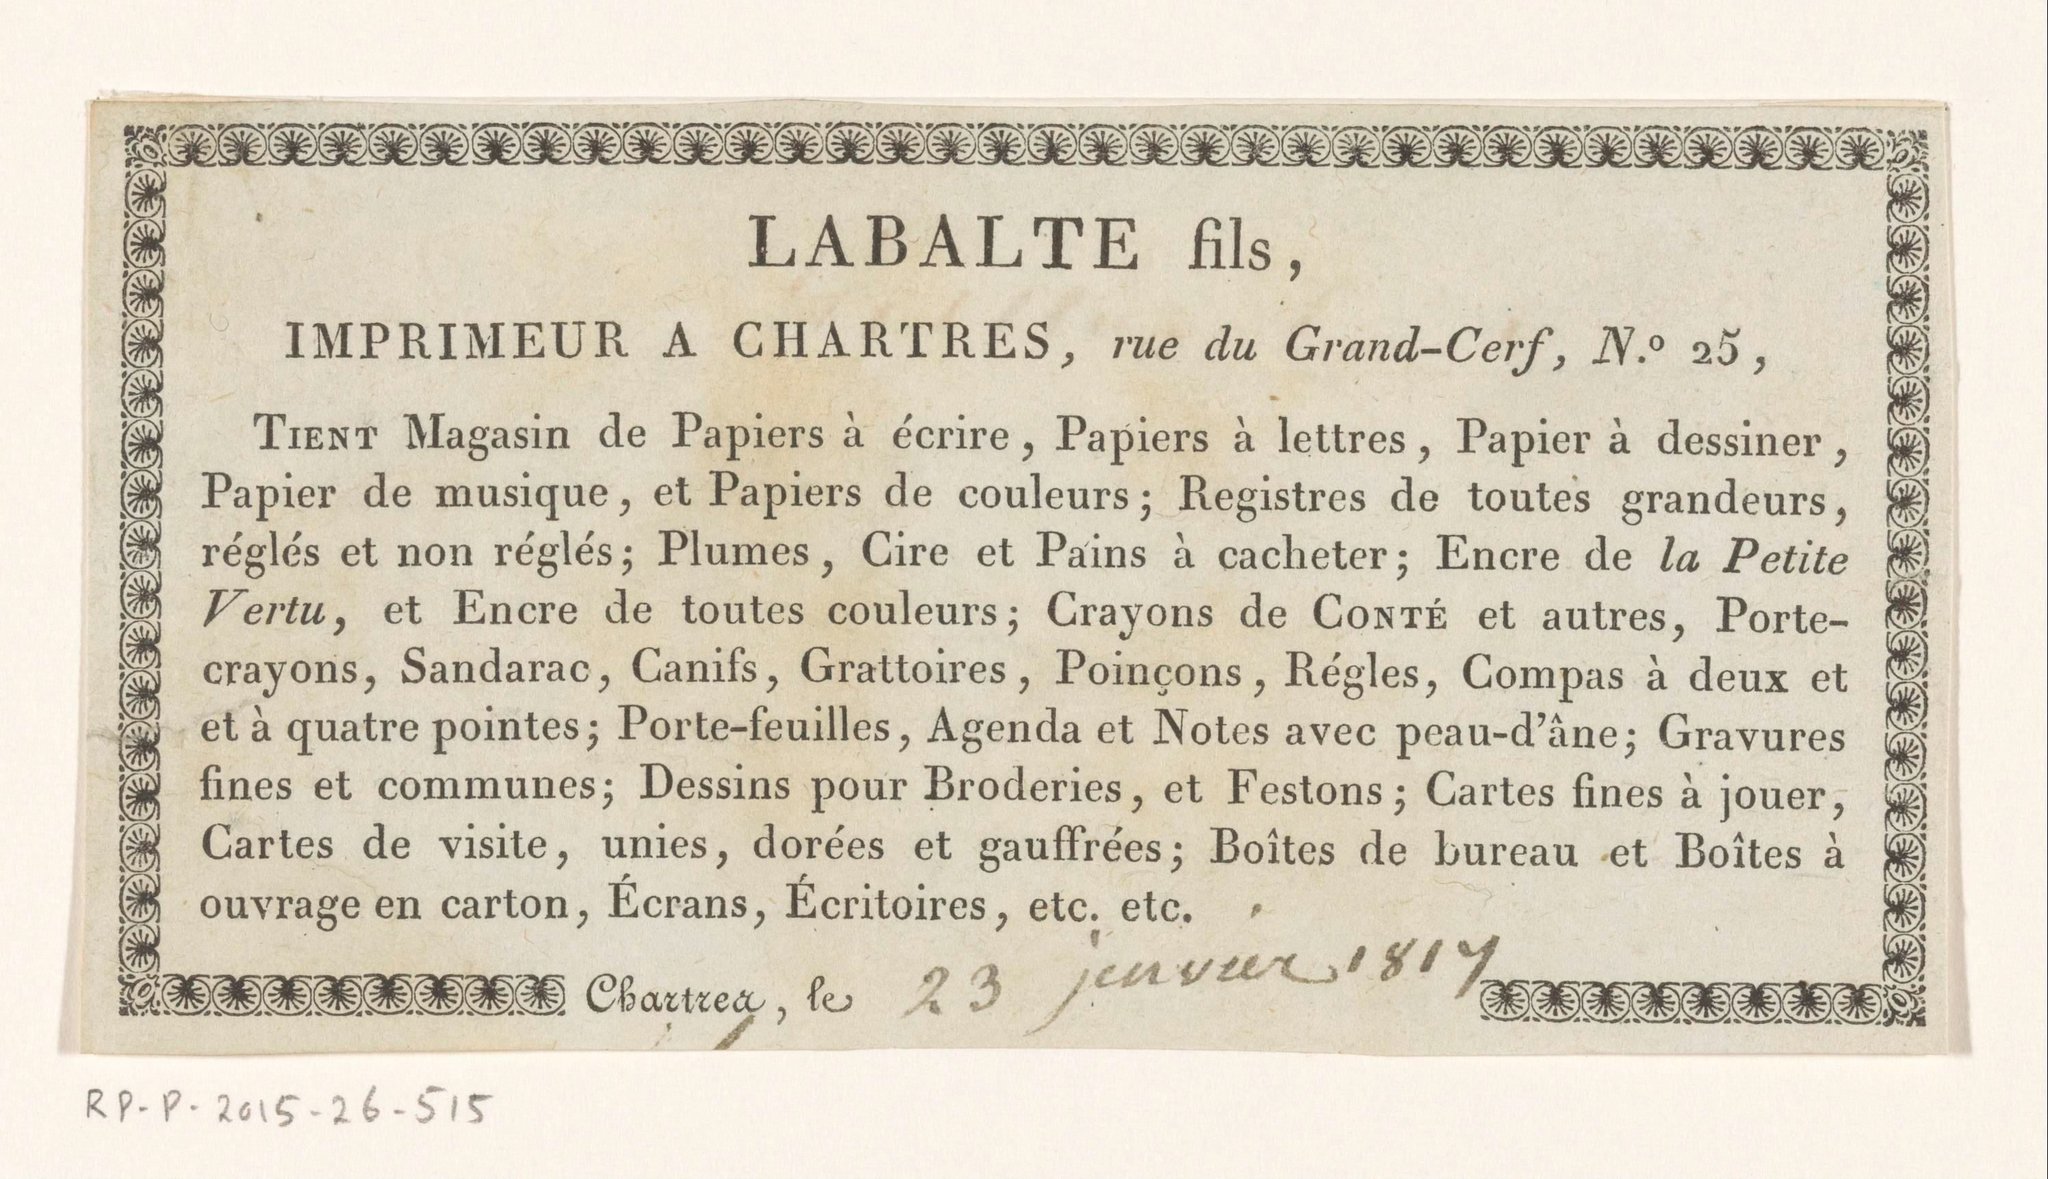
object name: print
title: Visitekaartje van Labalte fils, uitgeverij en verkoper van kantoorartikelen te Chartres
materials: ink, paper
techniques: letterpress printing, pen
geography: chartres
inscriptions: collector's mark: Lugt 4780, collector's mark: Lugt 2228